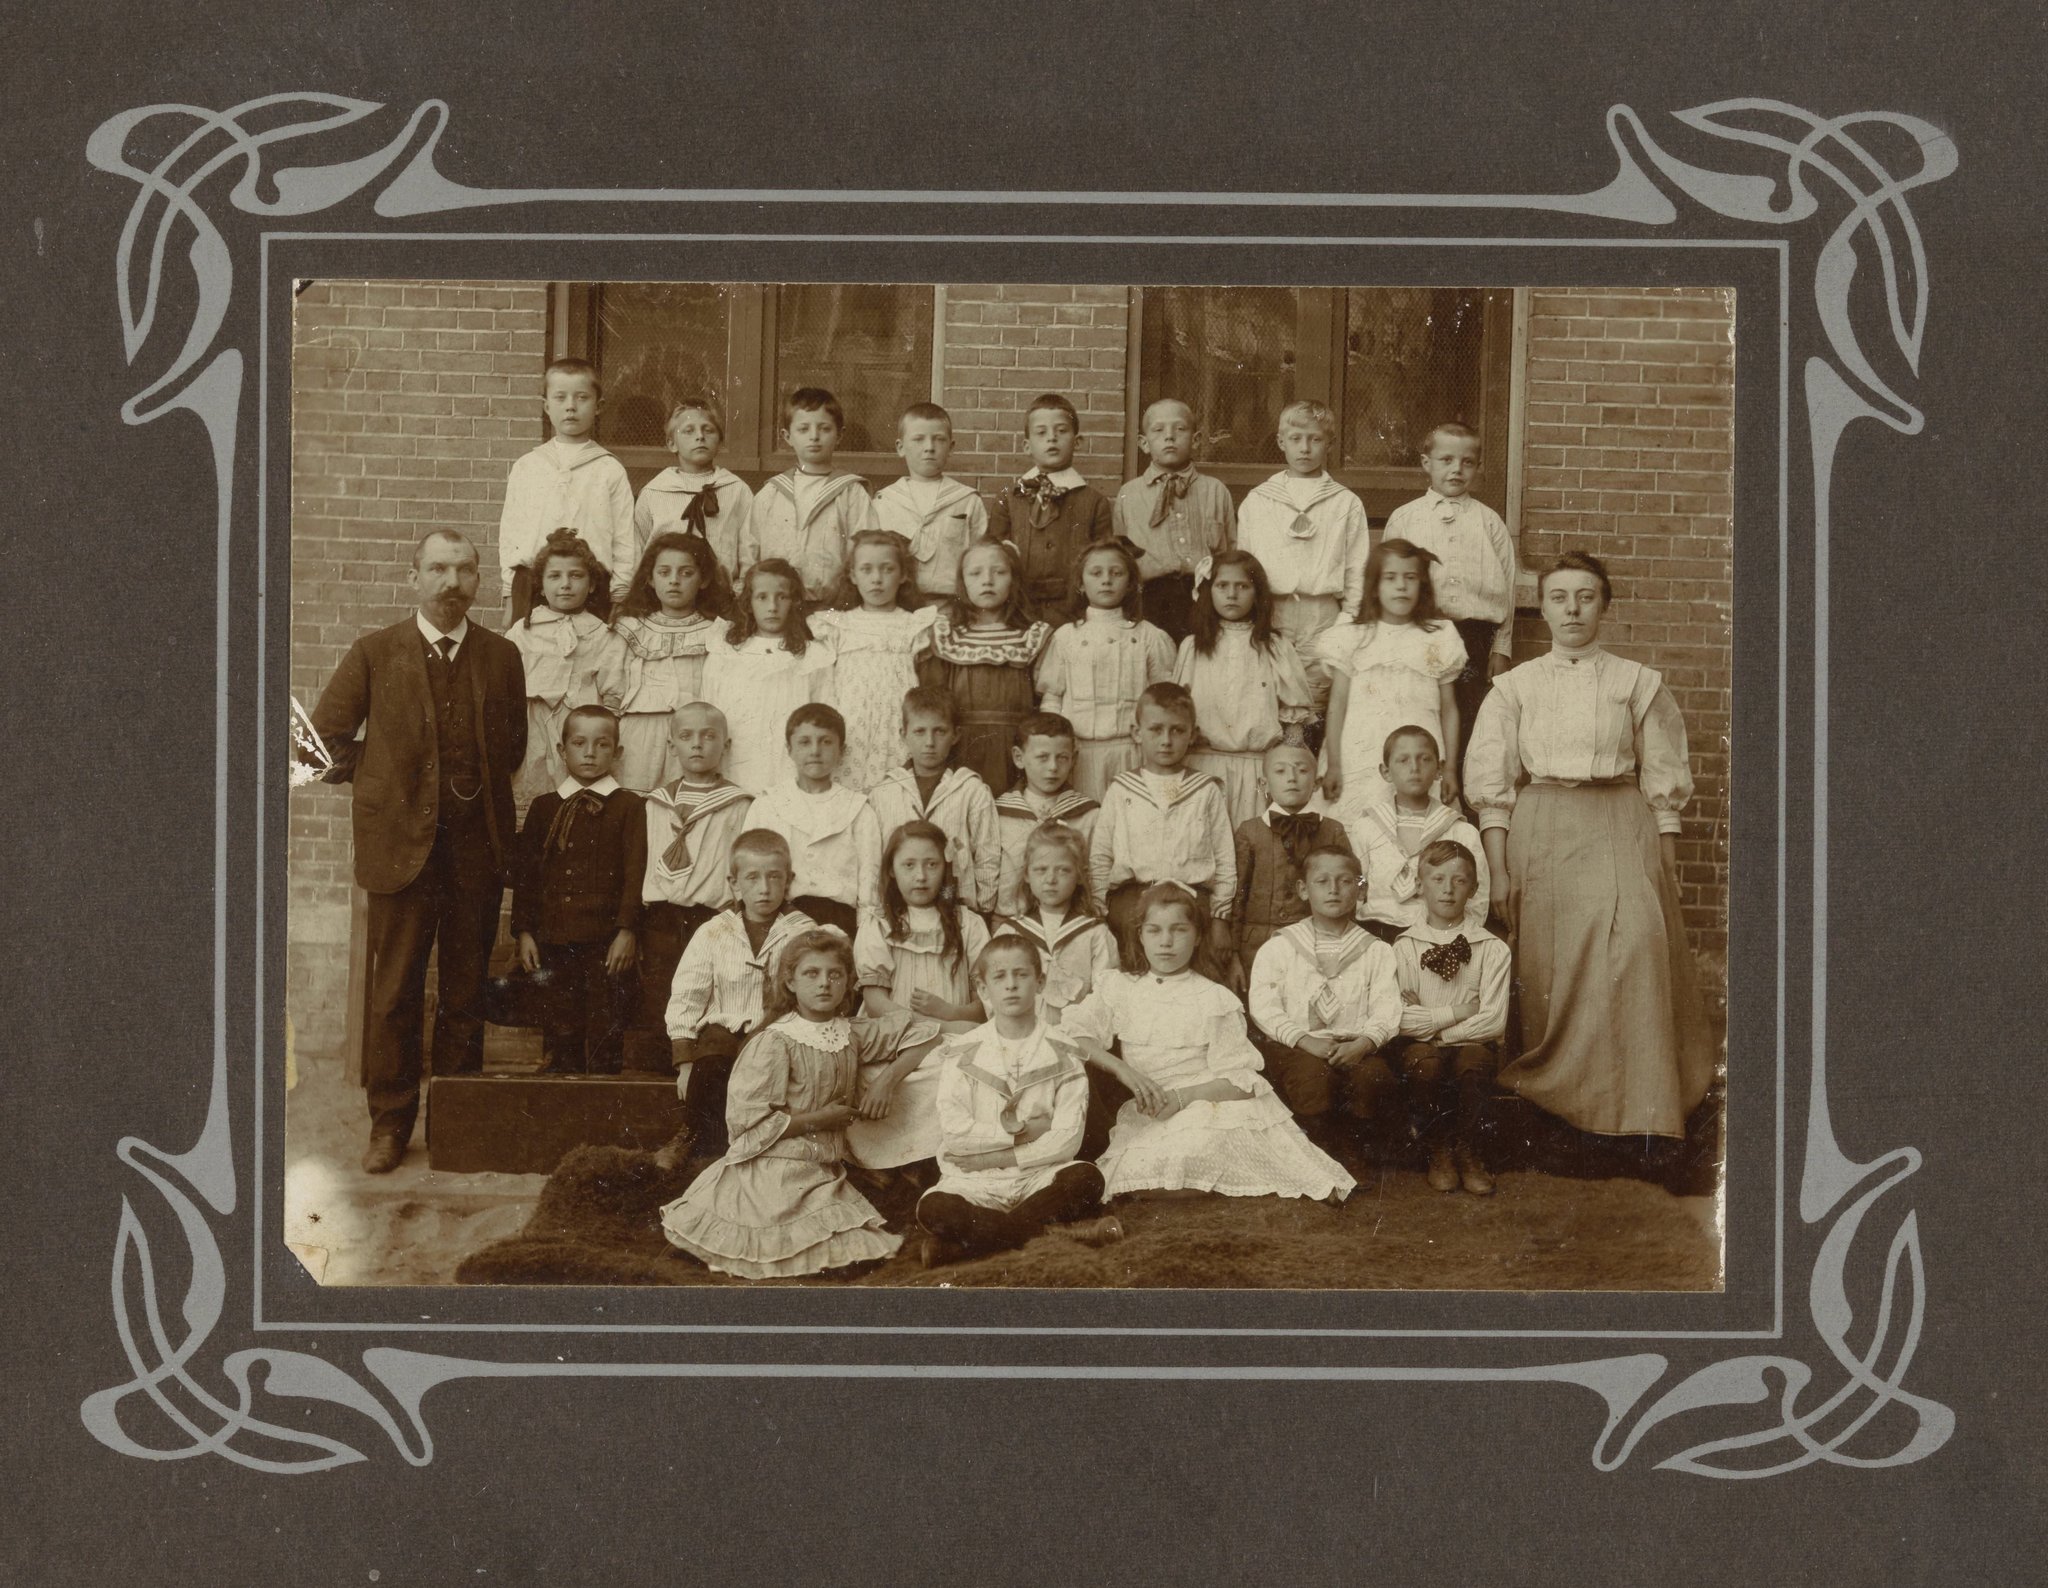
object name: photograph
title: Schoolfoto van een klas met kinderen, buiten bij school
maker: Anonymous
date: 1905-1915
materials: cardboard, photographic support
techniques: gelatin silver print